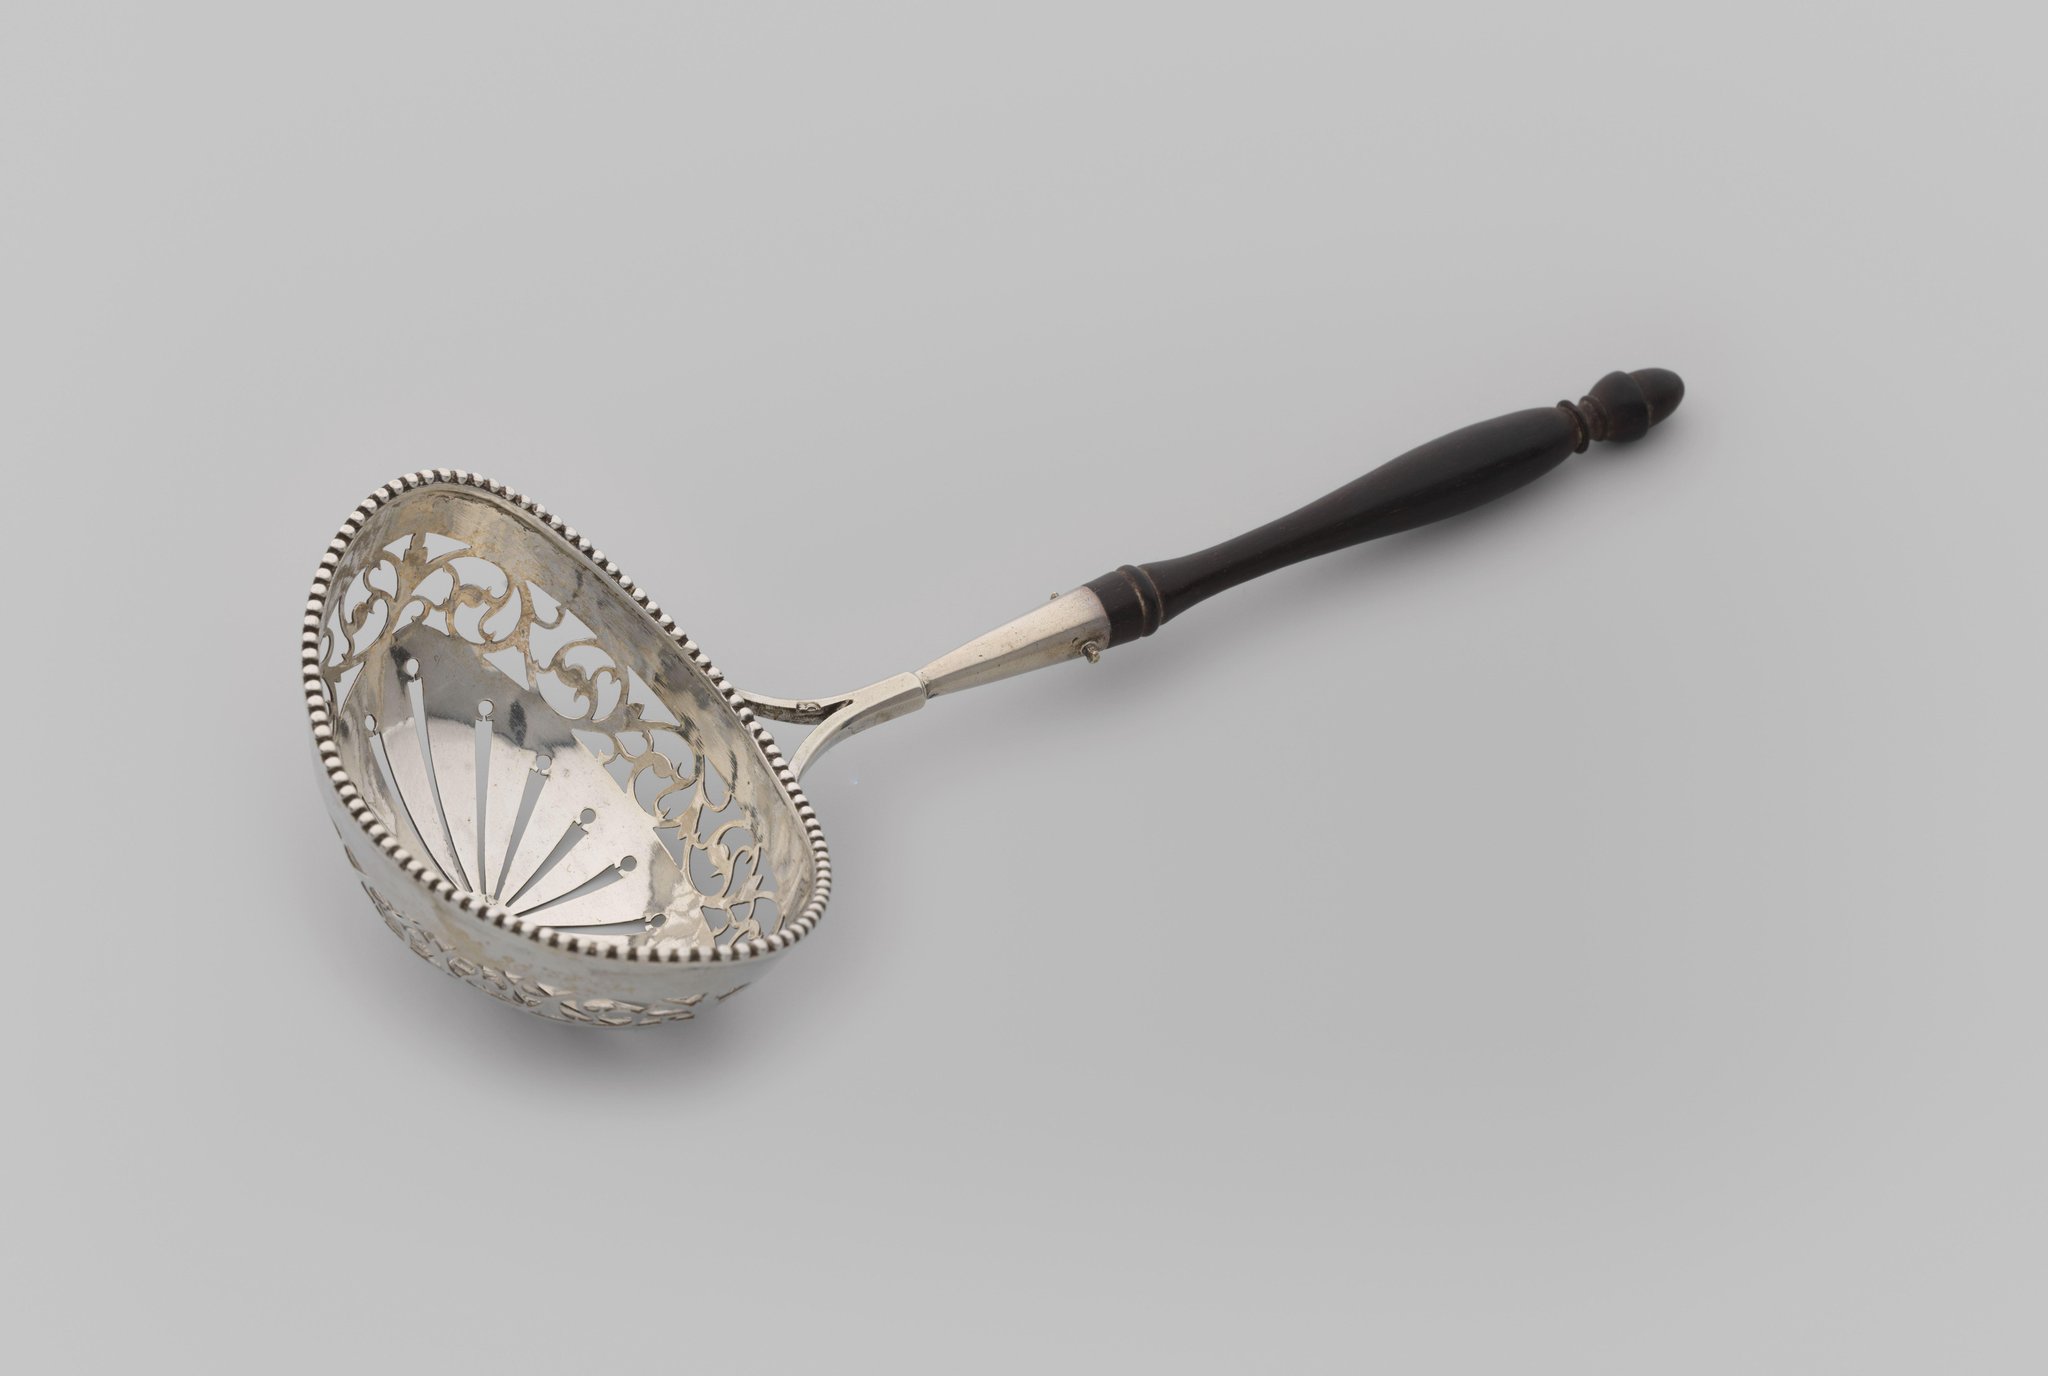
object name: spoon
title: Suikerstrooilepel met ovale, opengewerkte bak met parelrand en houten steel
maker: diederik willem rethmeyer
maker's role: silversmith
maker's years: 1756-1821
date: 1807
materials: wood, silver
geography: amsterdam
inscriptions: maker's mark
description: Strooilepels van zilver met geprofileerde ebbenhouten steel, met een ellipsvormige bak. Merken: Op de rand: D.W.R. (toegeschreven aan D.W. Rethmeyer van Lierten. Gekroonde O. Amsterdam, met jaarletter W = 1805. Genummerd A en B.